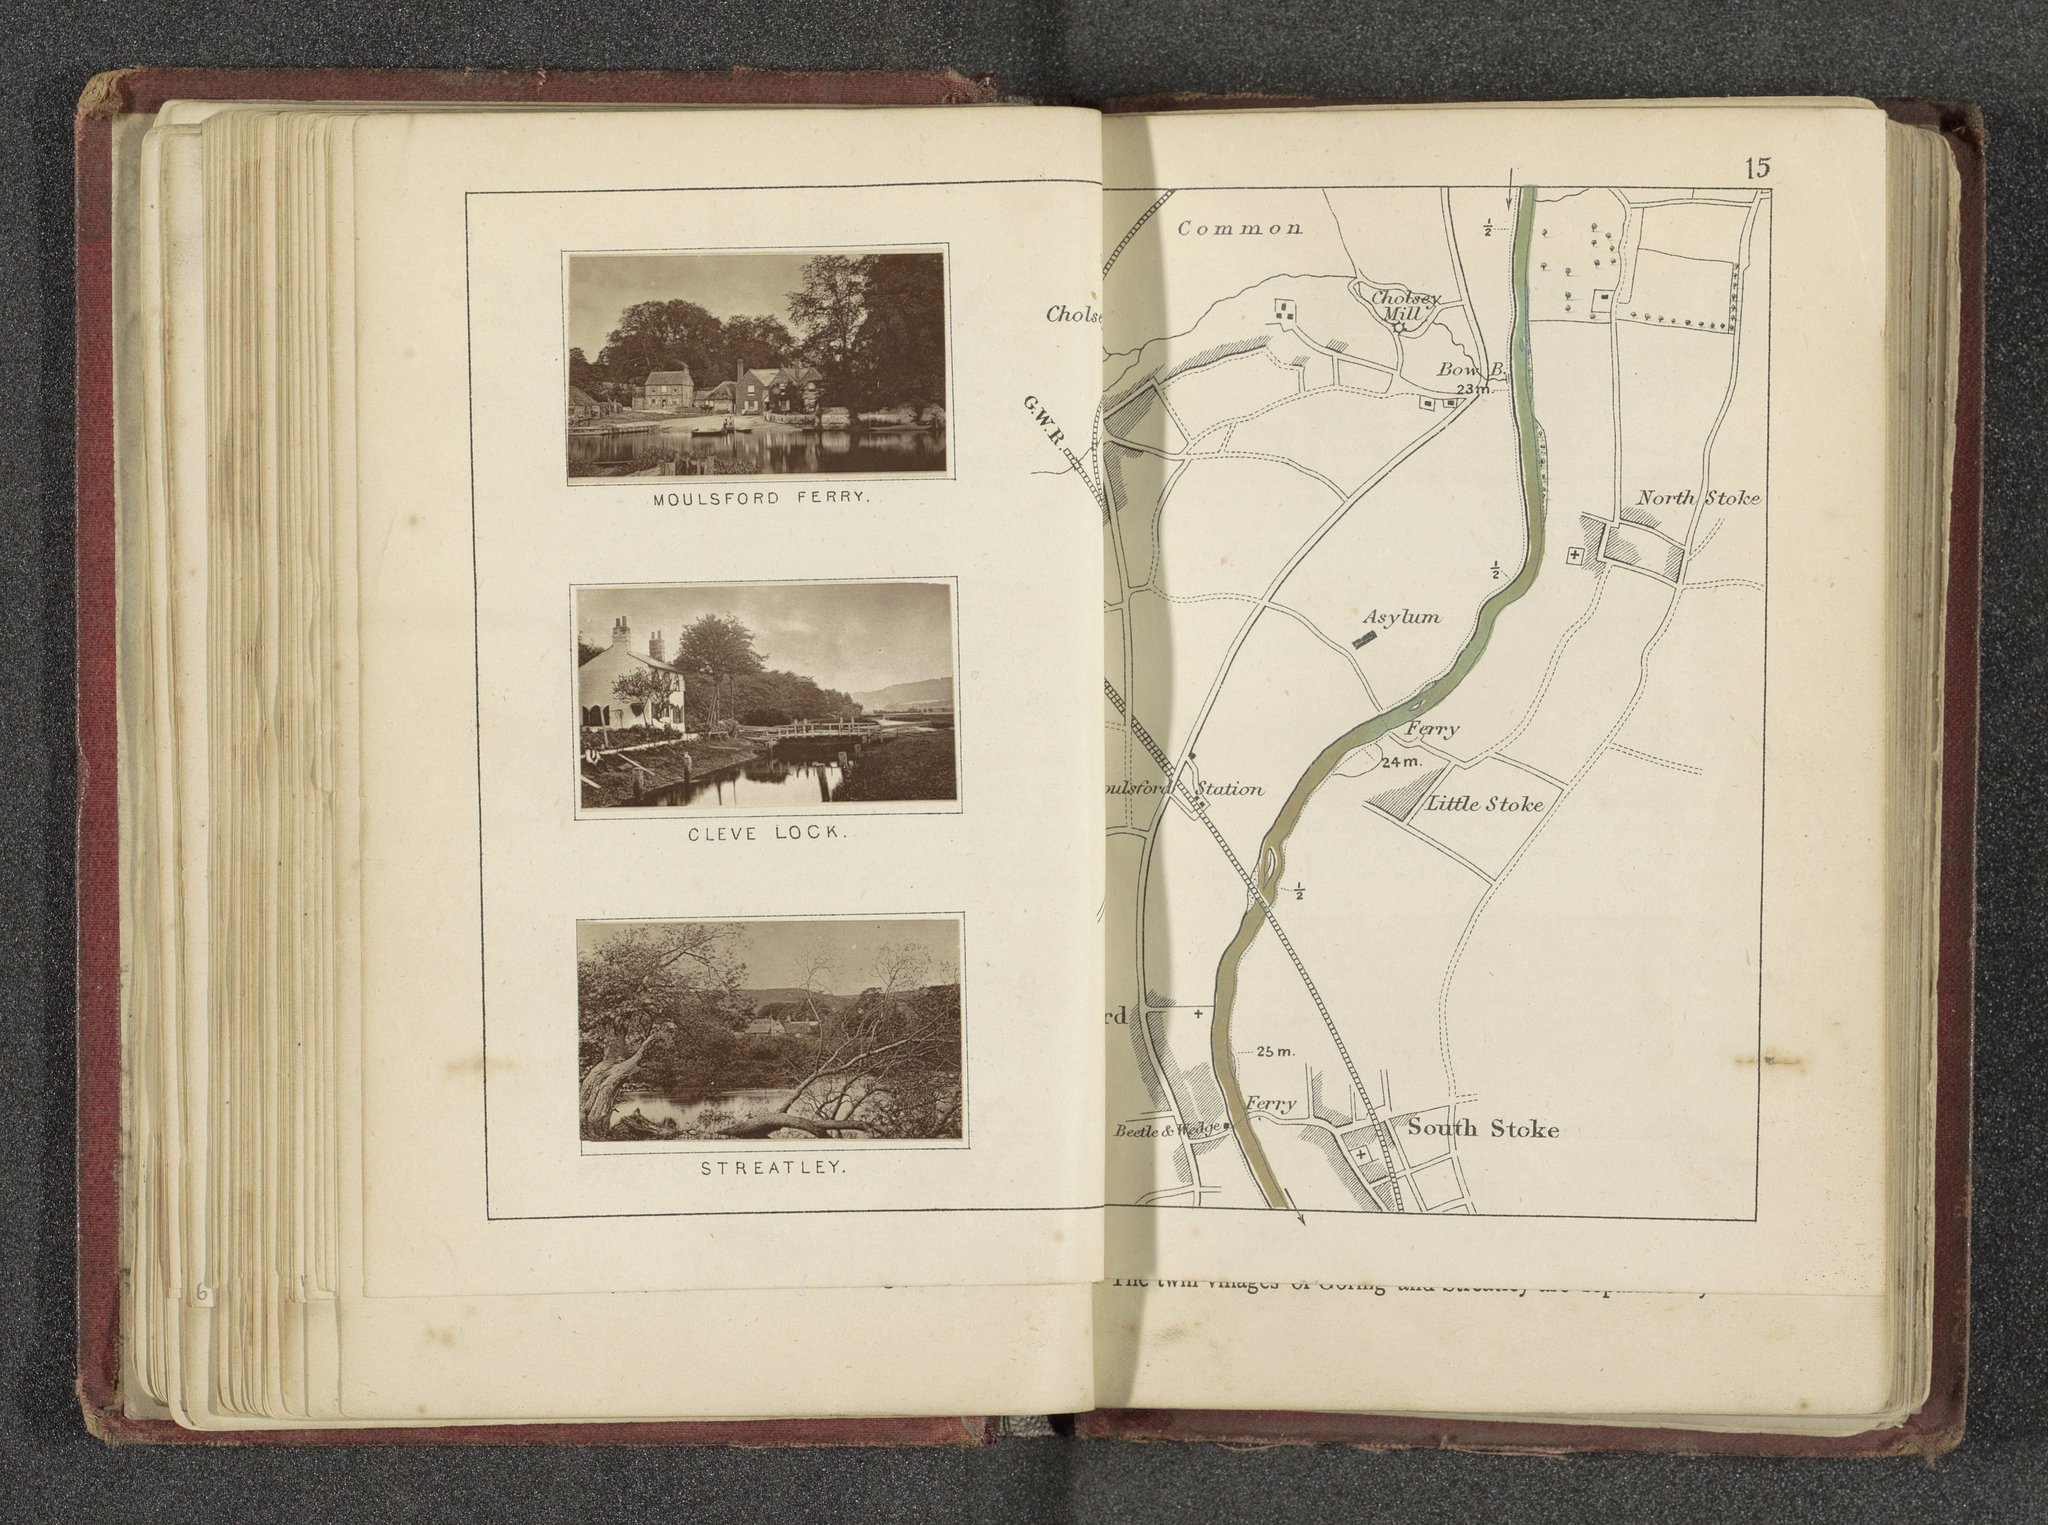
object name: print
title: Kaart met drie afbeeldingen van plaatsen langs de Theems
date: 1878-1879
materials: paper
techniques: engraving, woodburytype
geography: england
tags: sluice, weir, city-view, and landscape with man-made constructions, river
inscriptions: number: ‘15’, inscription: ‘Moulsford ferry. Cleve lock. Streatley.’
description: Boven: gezicht op de aanlegplaats van de veerboot bij Moulsford, midden: een sluis, onder: gezicht op Streatley over de Theems.